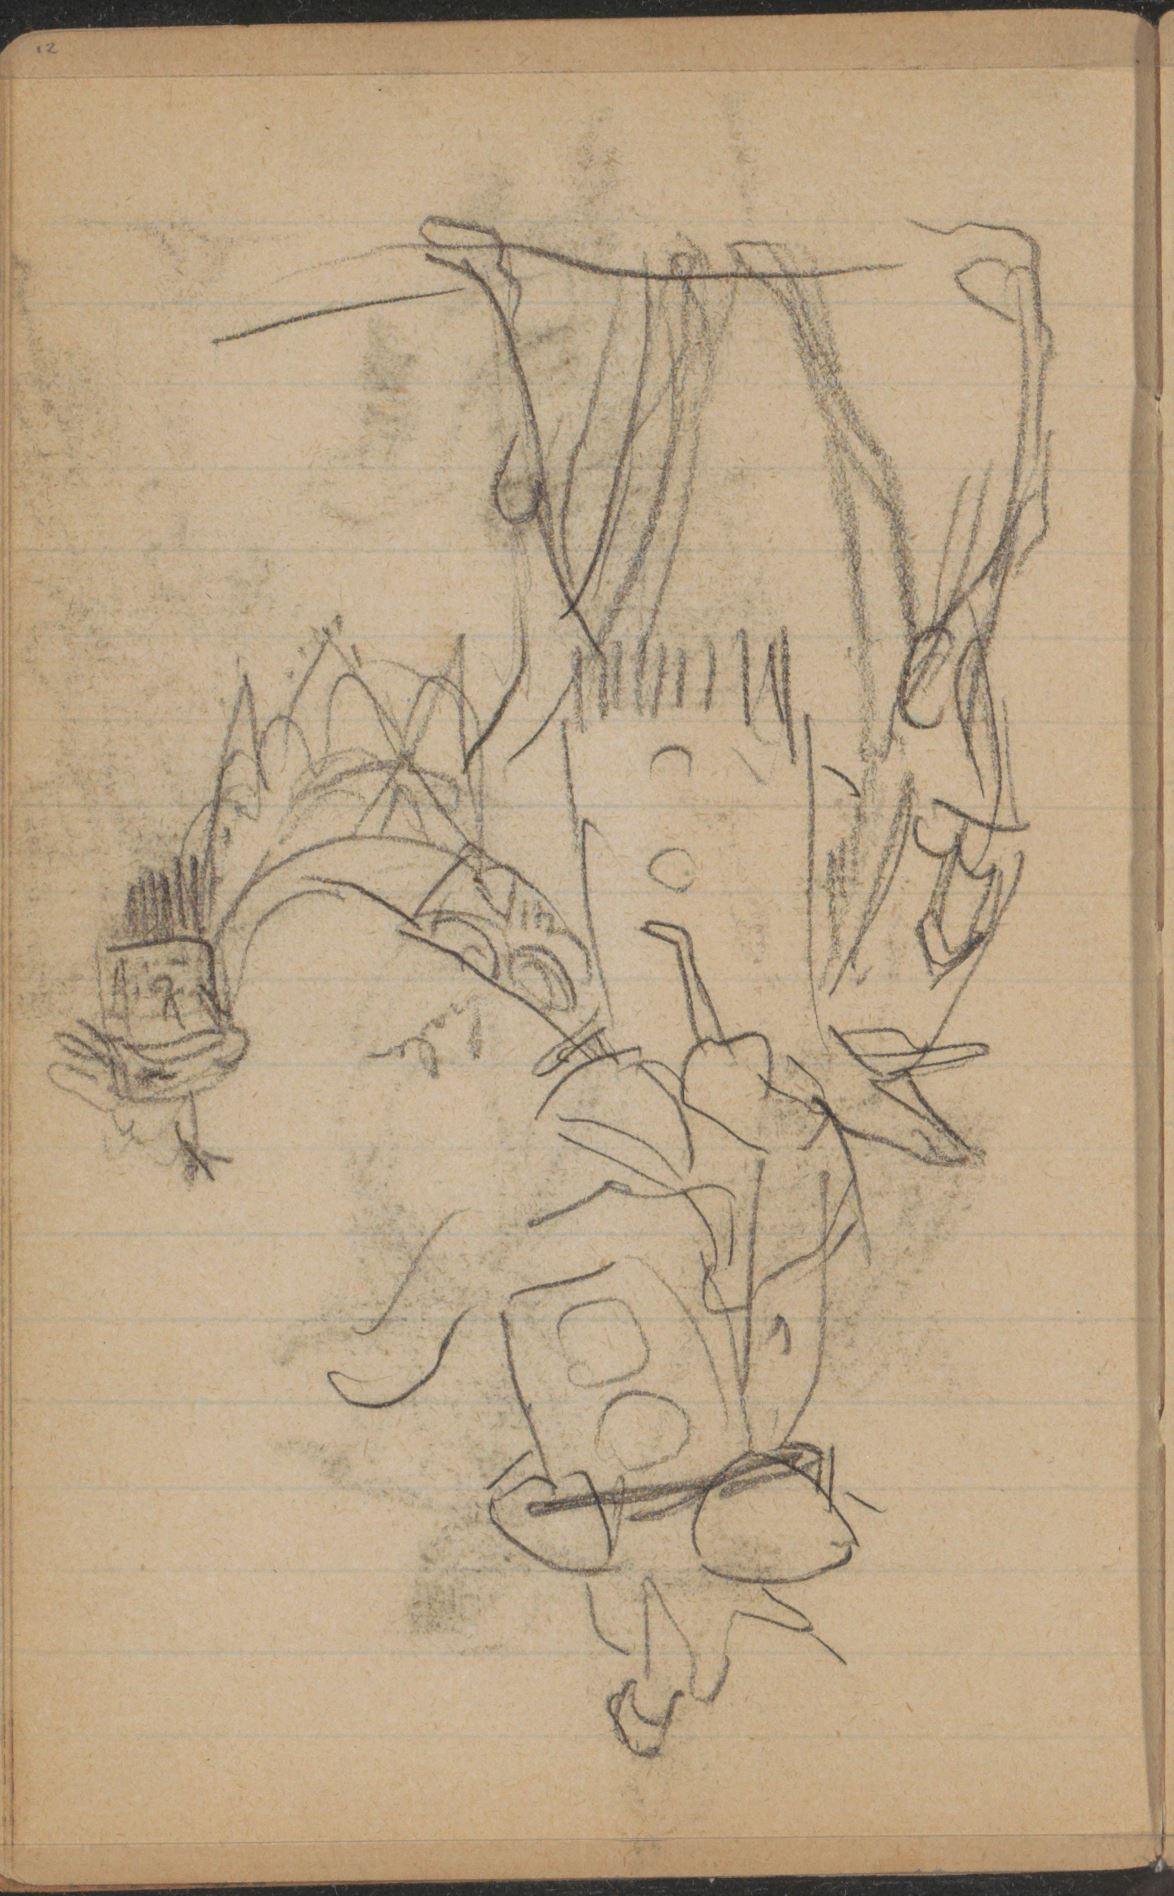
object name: sketchbook leaf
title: Egyptenaar op een kameel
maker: marius bauer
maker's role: draughtsman, print maker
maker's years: 1867-1932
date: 1894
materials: chalk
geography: egypt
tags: hoofed animals: camel, sitting figure, africans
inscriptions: kleurnotitie, handgeschreven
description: De kameel draagt verschillende decoraties. Pagina 12 uit een schetsboek met 48 bladen.